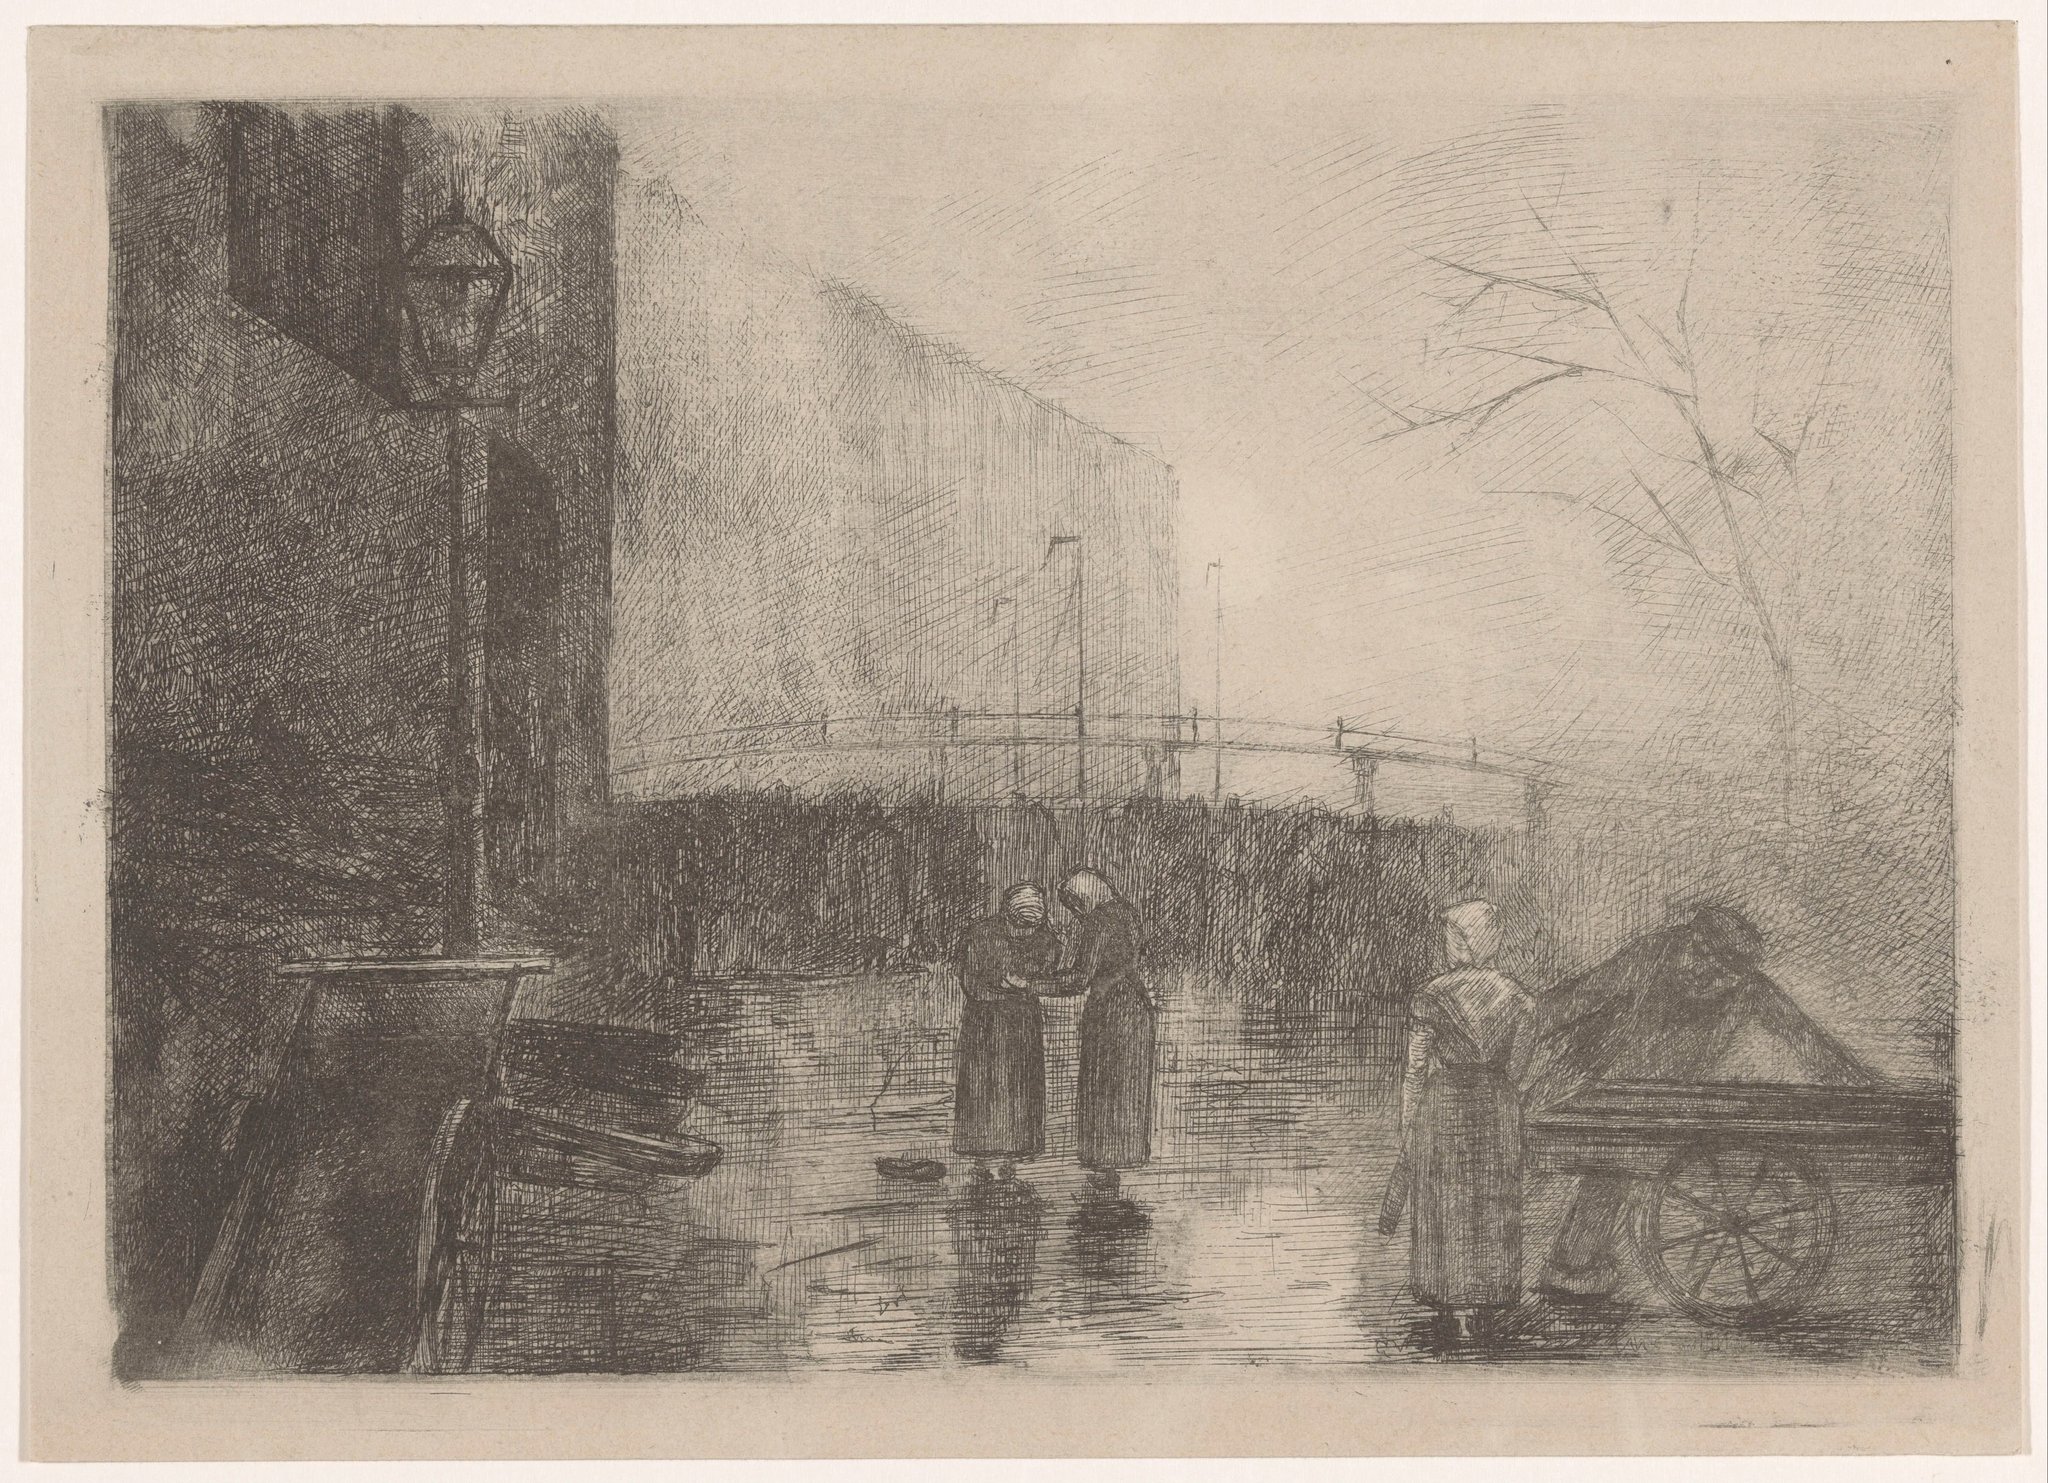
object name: print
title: Stadsgezicht bij nevelachtig weer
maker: simon moulijn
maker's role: draughtsman, print maker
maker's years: 1866-1948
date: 1886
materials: paper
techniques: printmaking, etching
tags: hand-cart, square, place, circus, etc., bridge, mist, fog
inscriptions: collector's mark: Lugt 2228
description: Gezicht op een donker plein. Rechts op de voorgrond een man en vrouw bij een handkar. Op de achtergrond een brug.